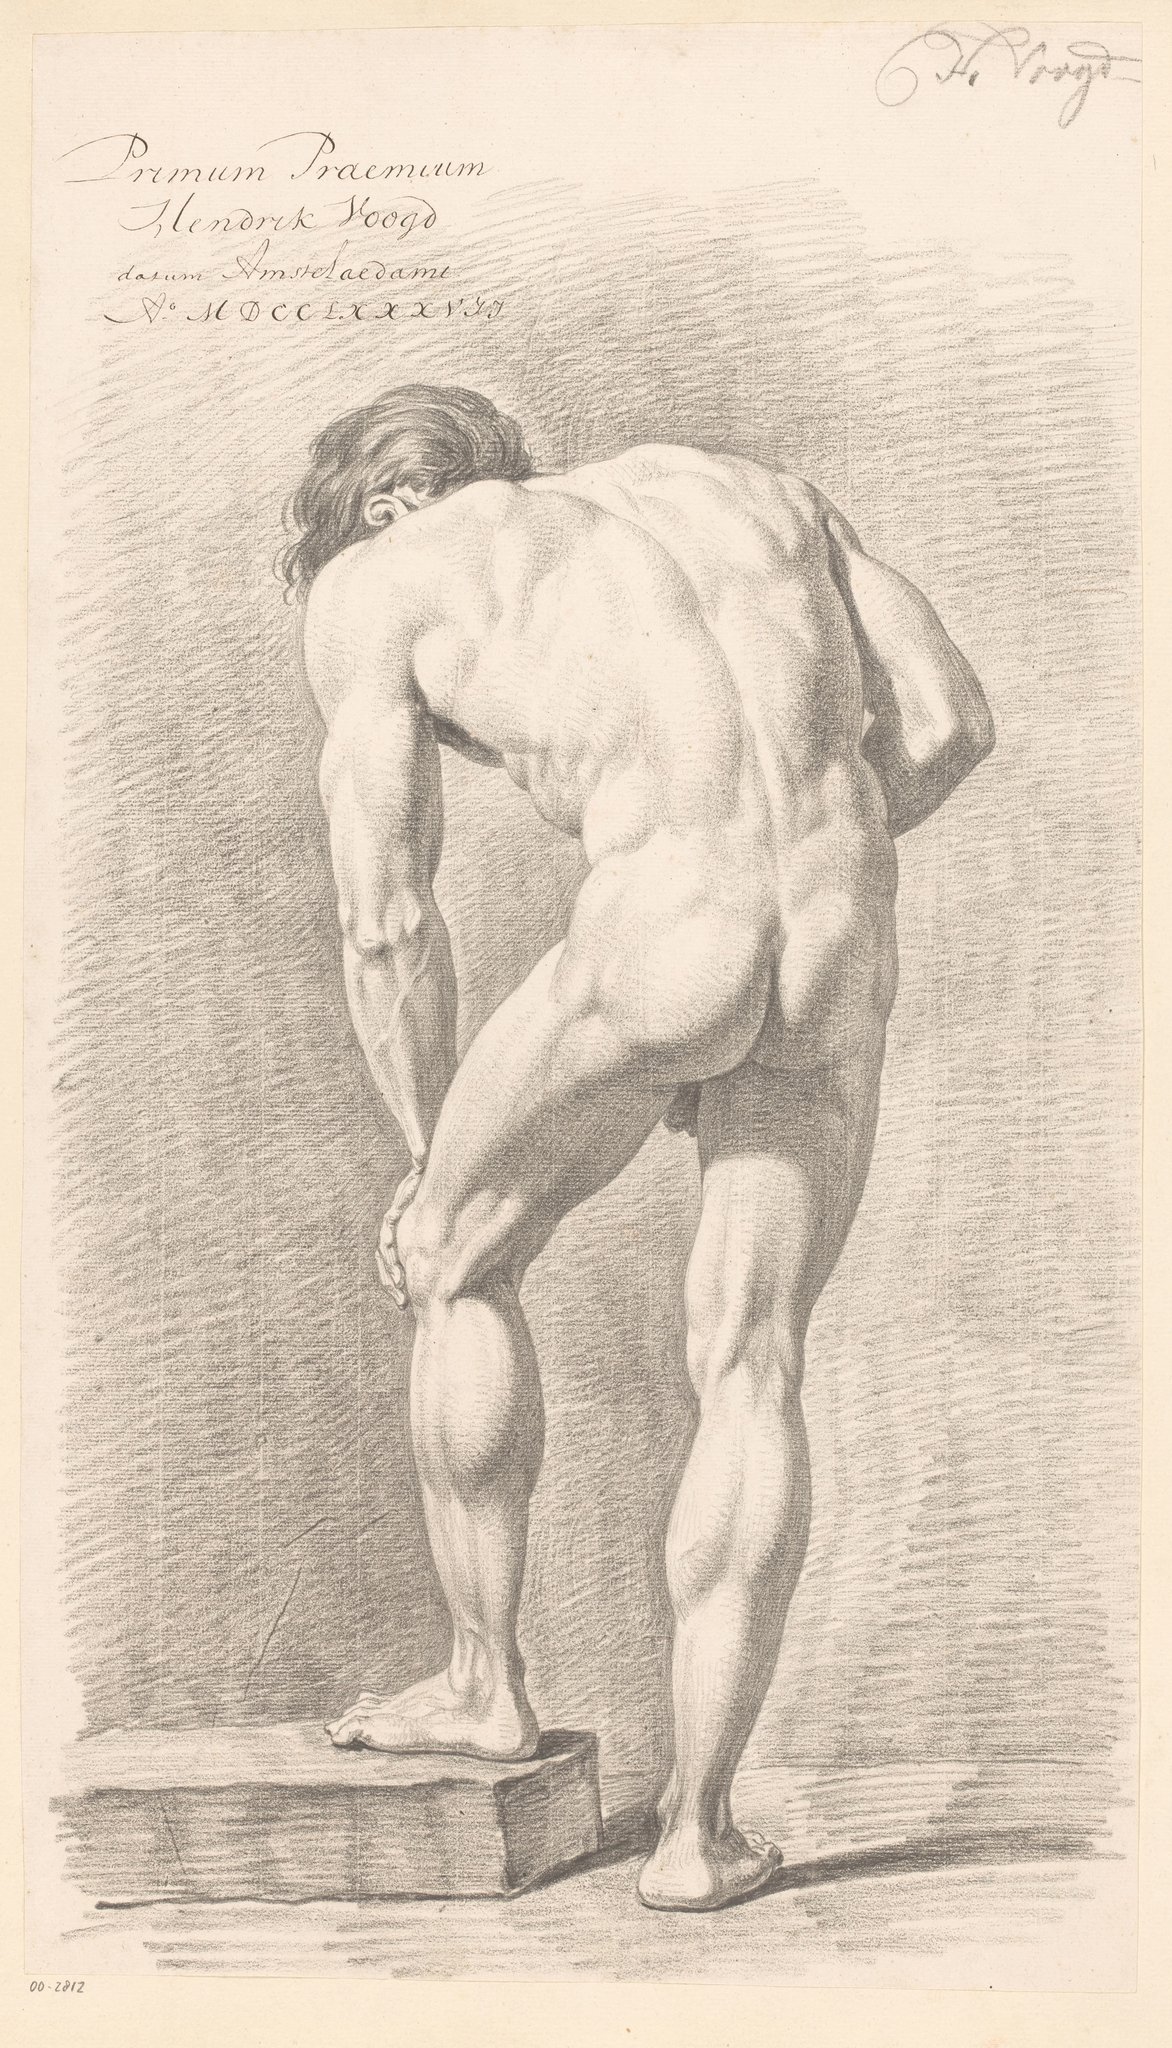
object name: drawing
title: Staand mannelijk naakt, op de rug gezien (1e prijs 1787)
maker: hendrik voogd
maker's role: draughtsman, painter, print maker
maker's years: 1768-1839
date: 1787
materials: chalk, paper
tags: standing figure (+ nude human being)